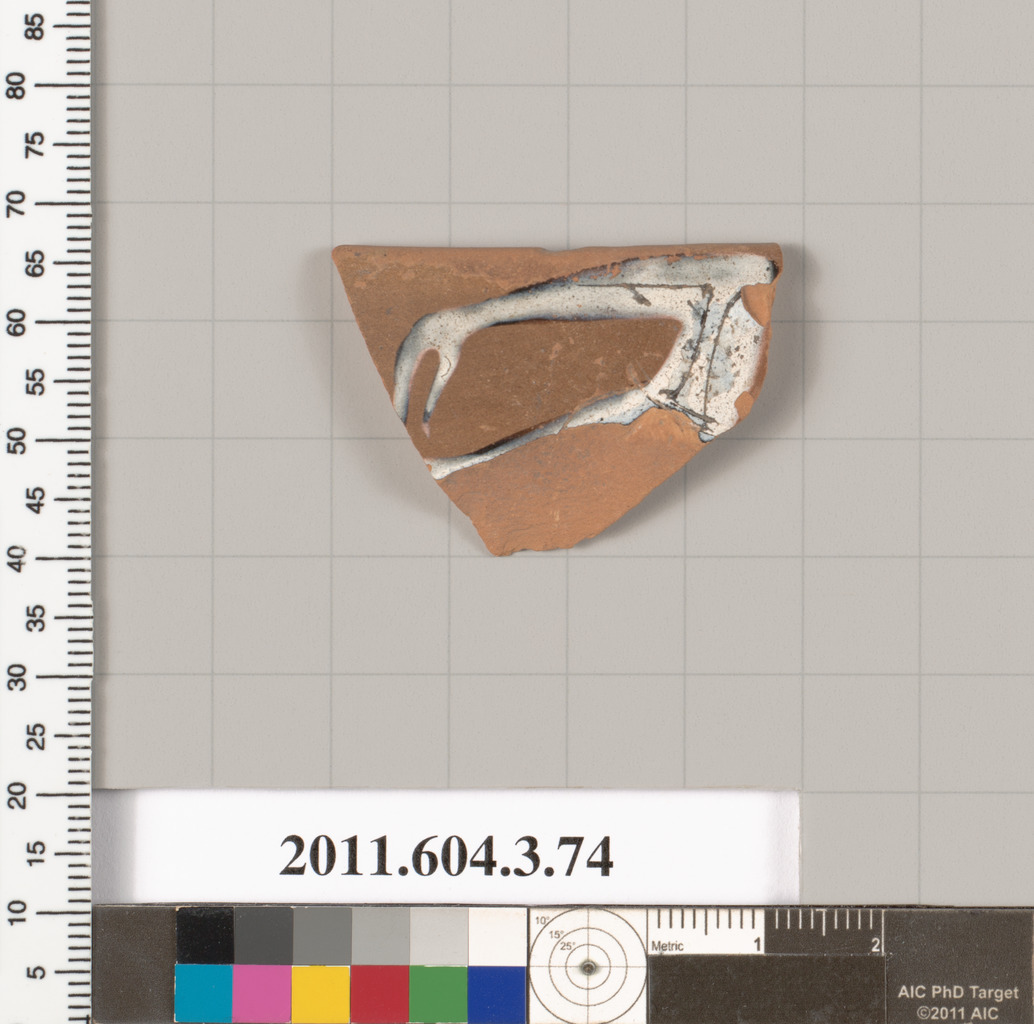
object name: amphora fragment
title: Terracotta fragment of an amphora (jar)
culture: greek, attic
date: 500-468 BCE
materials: terracotta